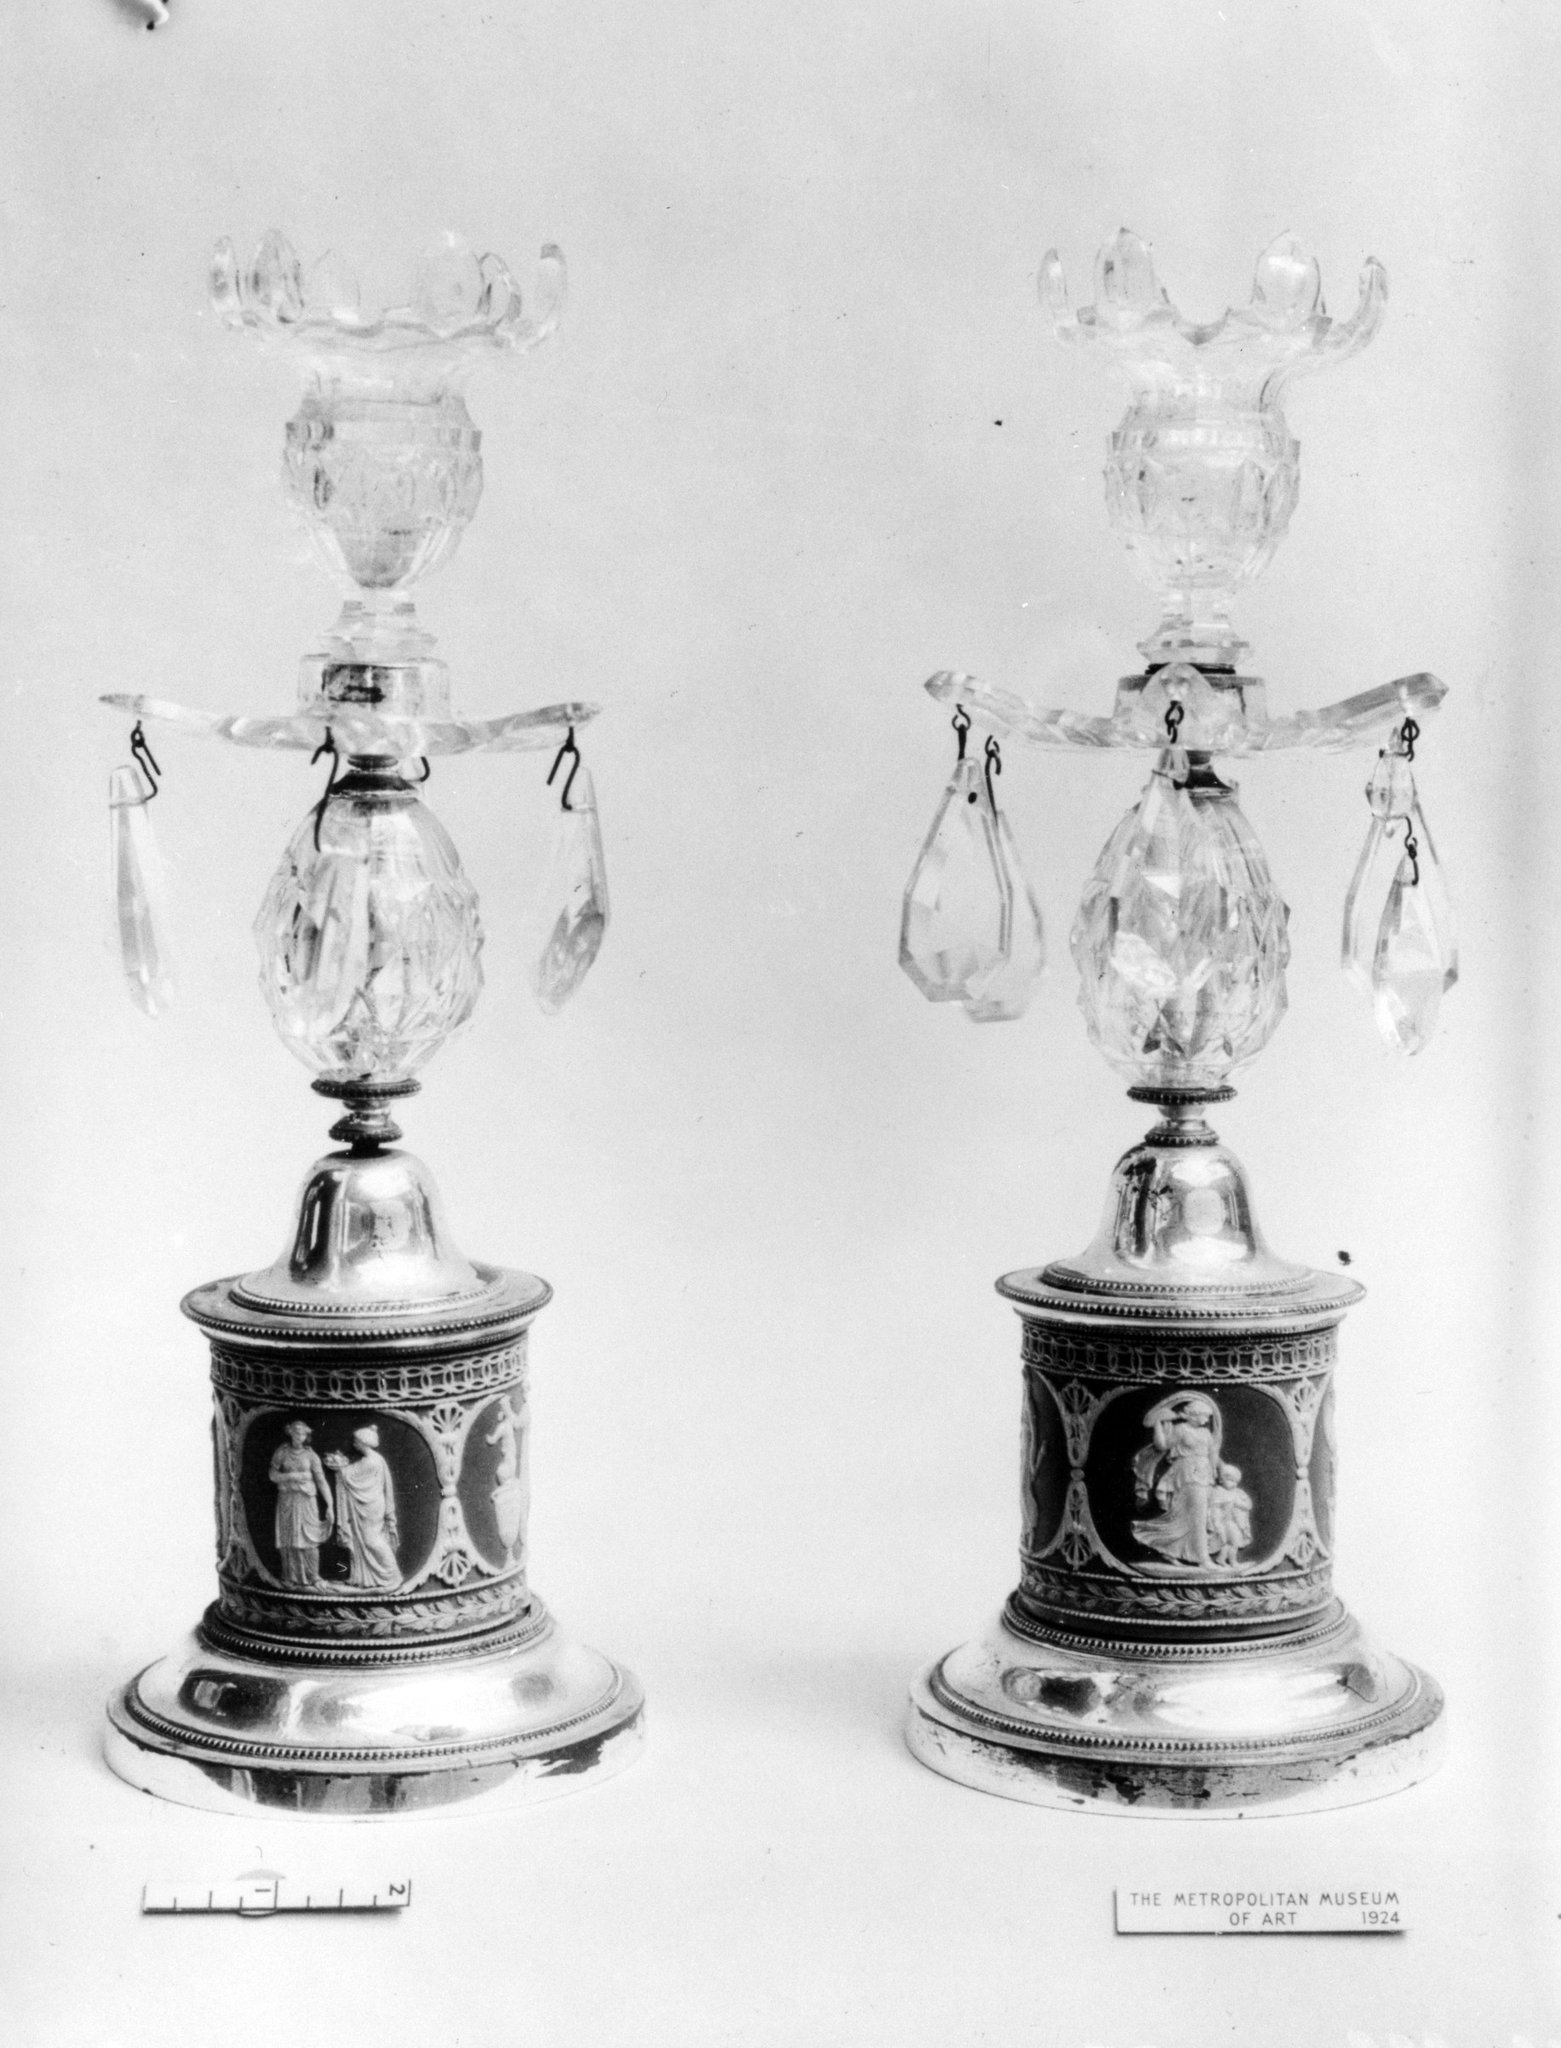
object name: candlestick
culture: british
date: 1800-1830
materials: earthenware, glass, metal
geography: england